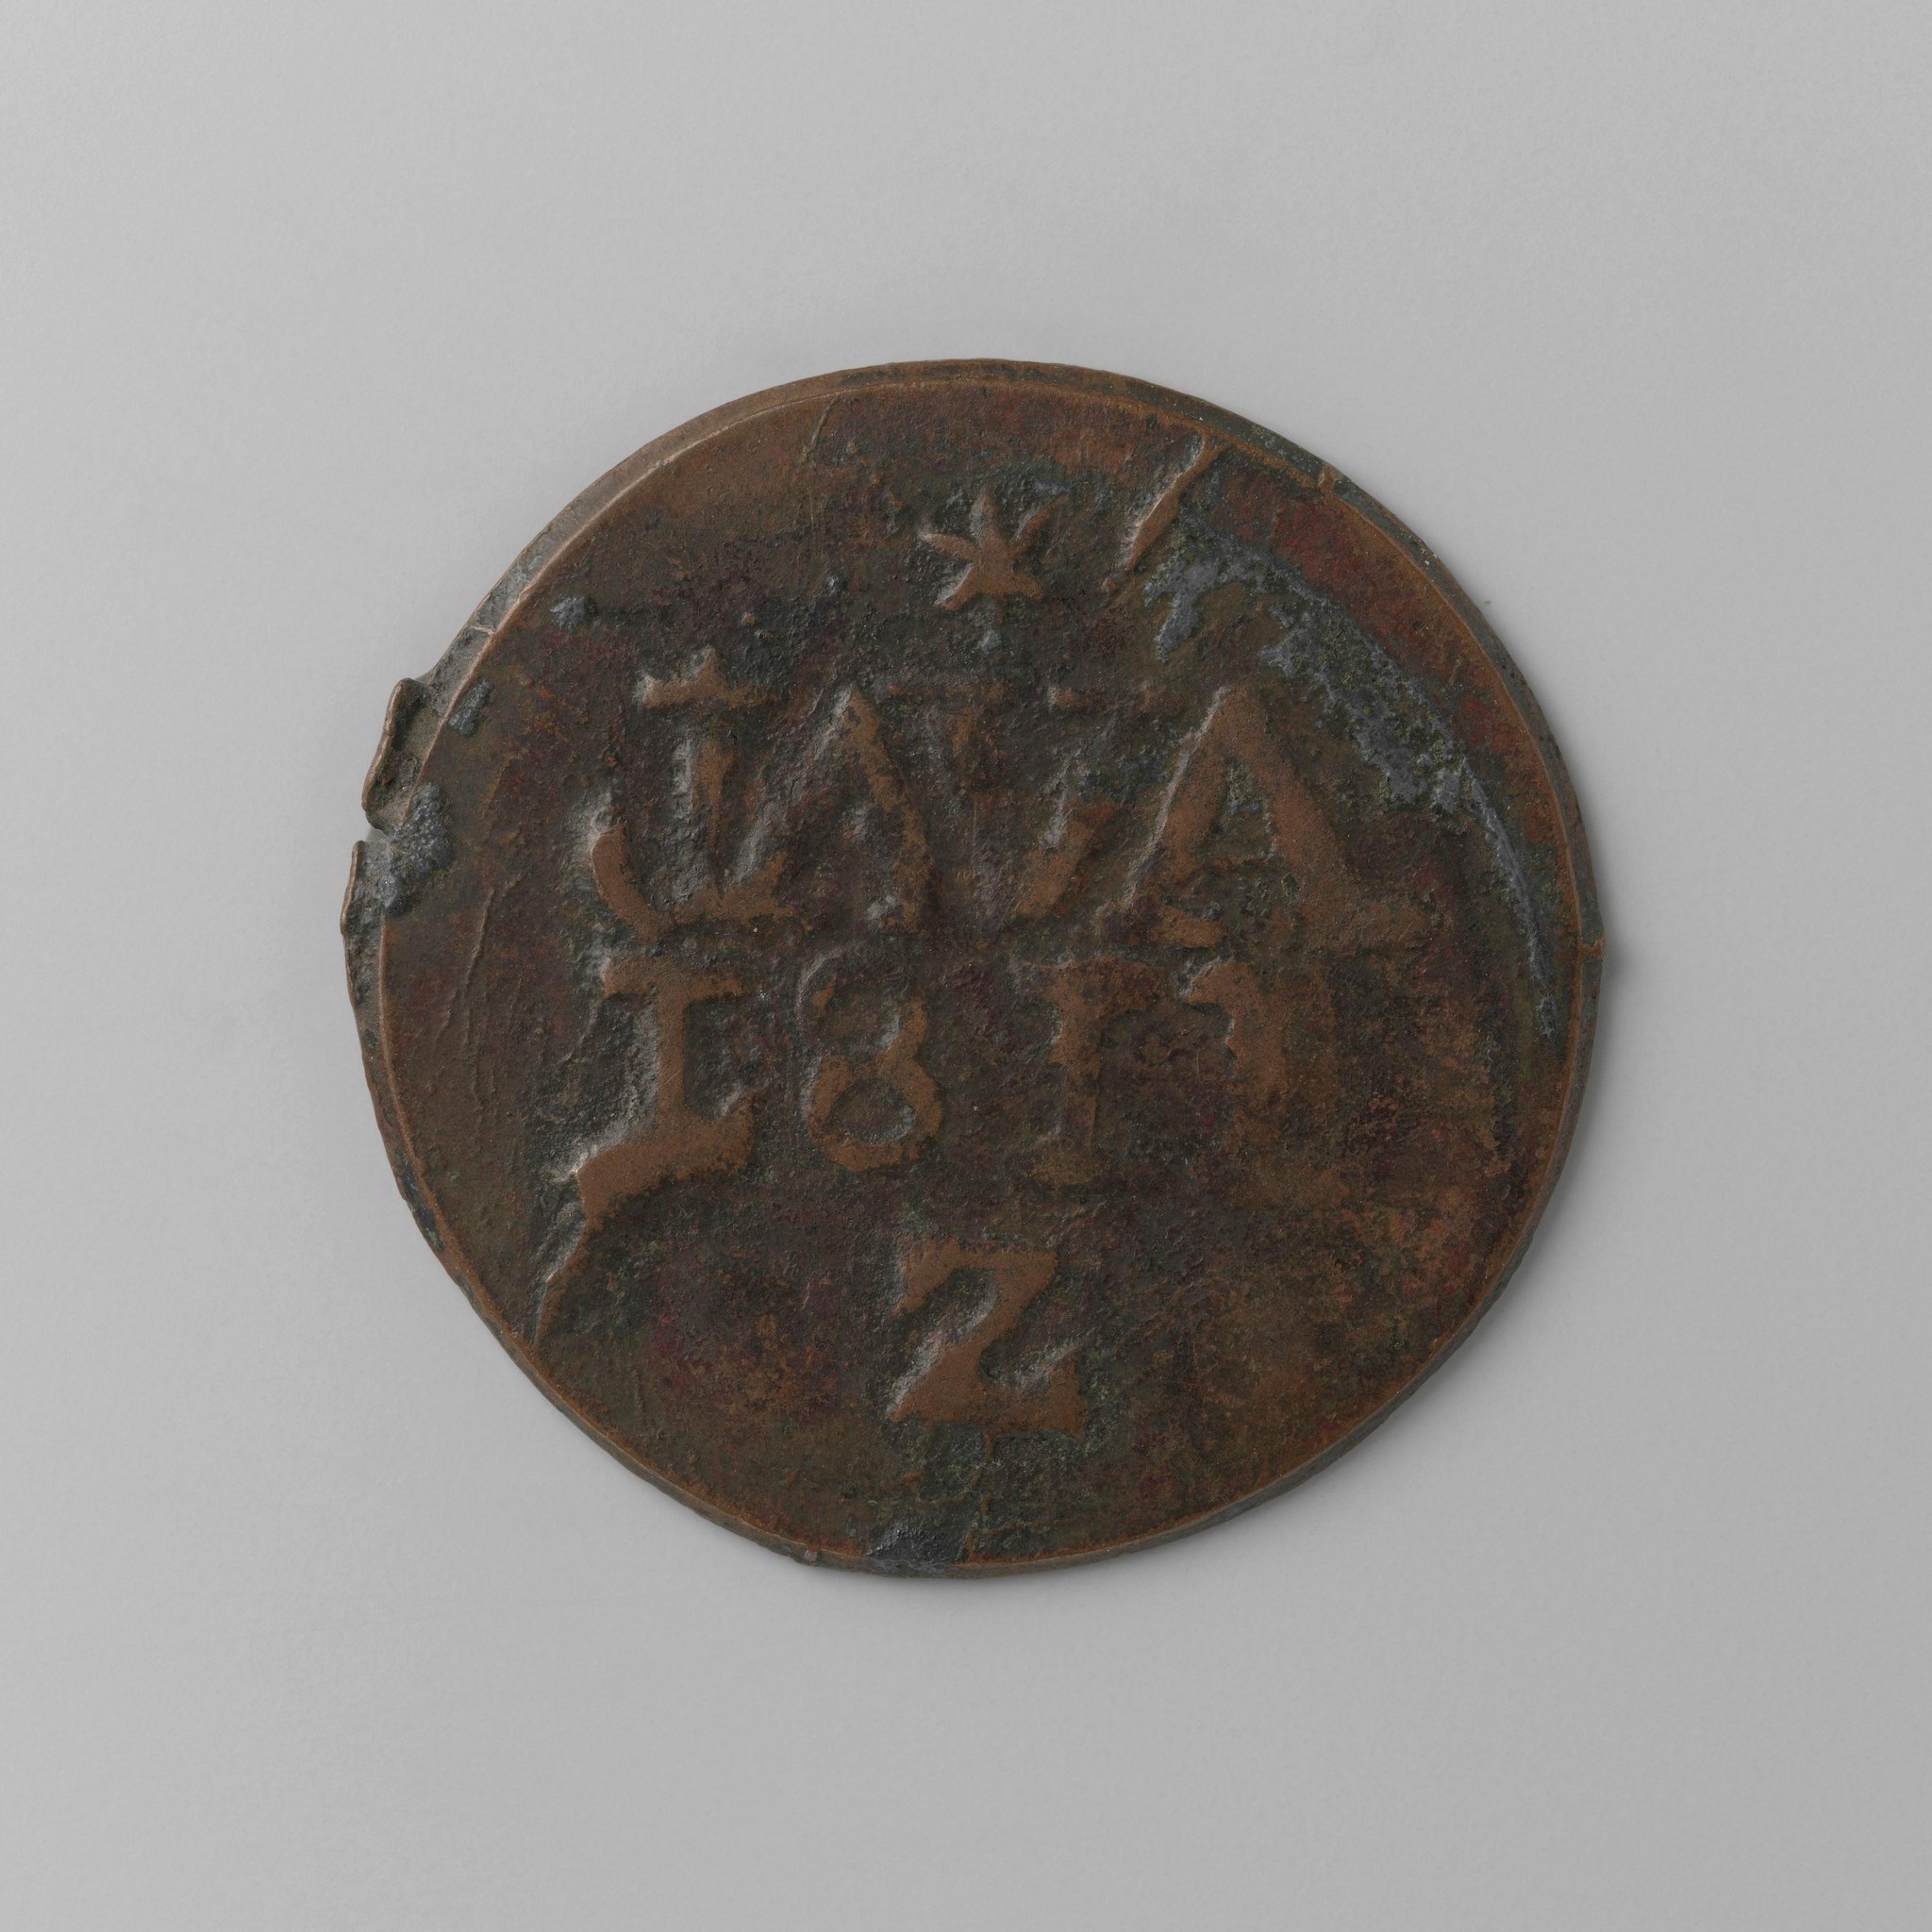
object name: coin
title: Nederlands Indië, duit Java,1811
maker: napoleon i (emperor of the french)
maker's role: generaal, keizer, staatsman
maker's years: 1769-1821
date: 1811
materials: copper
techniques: striking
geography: surabaya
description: Koperen munt. Voorzijde: initialen L en N van Lodewijk Napoleon. Daarboven muntteken. Keerzijde: eenregelig opschrift, waaronder jaartal. Boven opschrift muntteken en onder jaartal muntmeesterteken Z [=muntmeester Zwekkert].